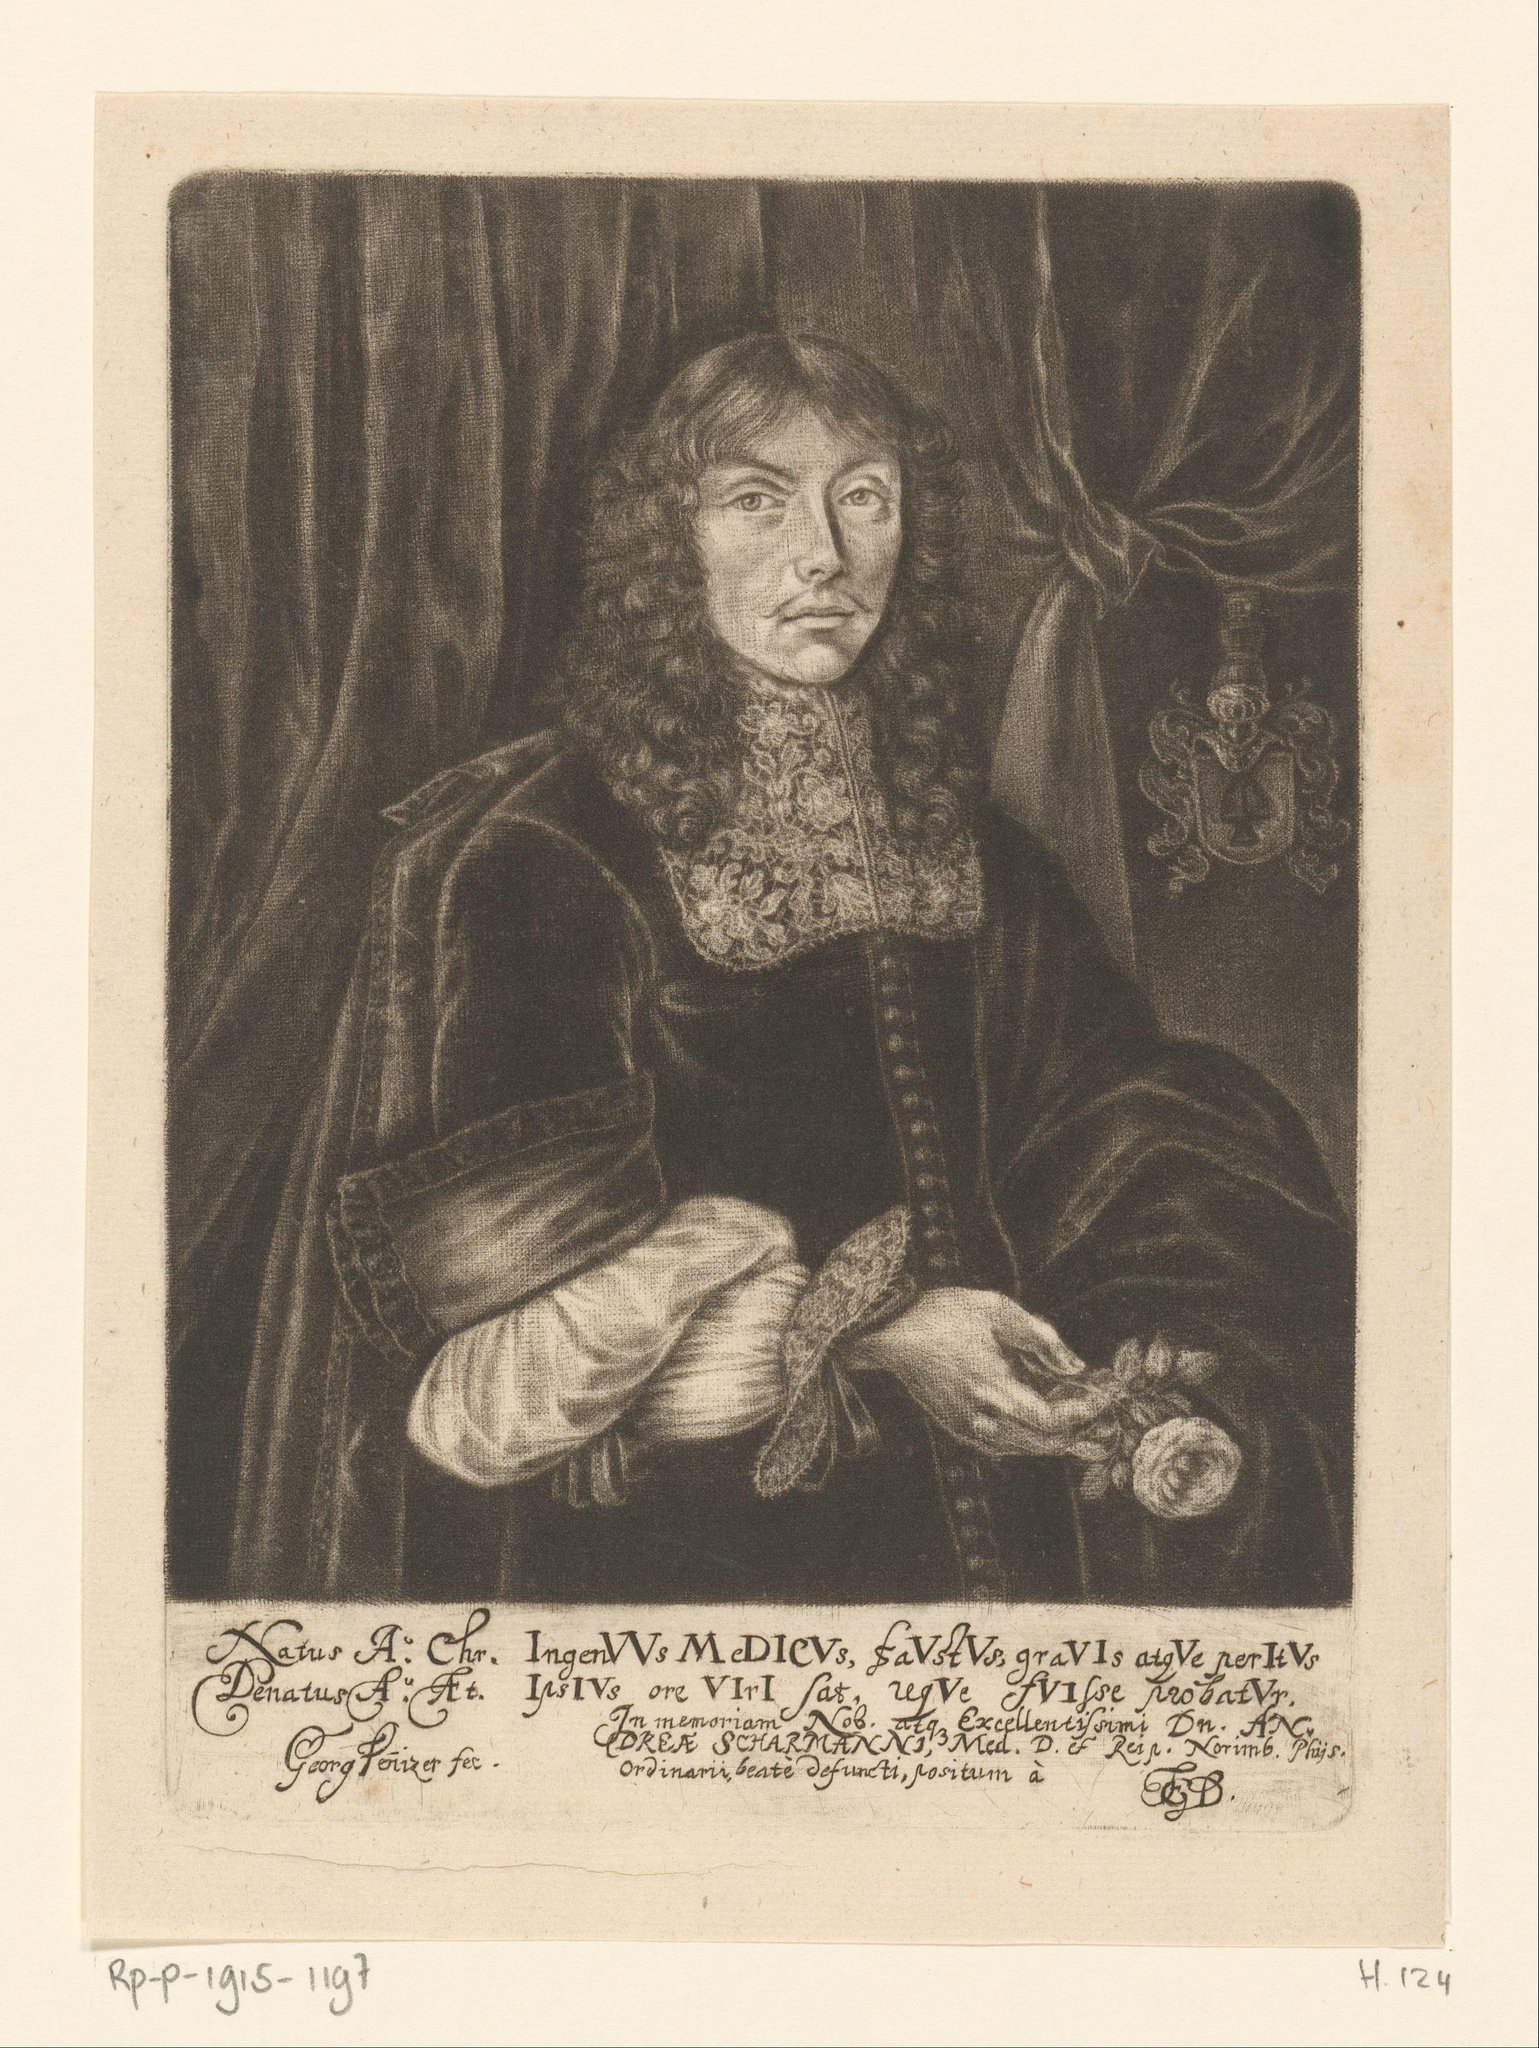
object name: print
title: Portret van Andreas Scharmann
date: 1656-1722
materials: paper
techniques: mezzotint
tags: historical persons, physician, doctor, flowers: rose, armorial bearing, heraldry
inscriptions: collector's mark: Lugt 2228